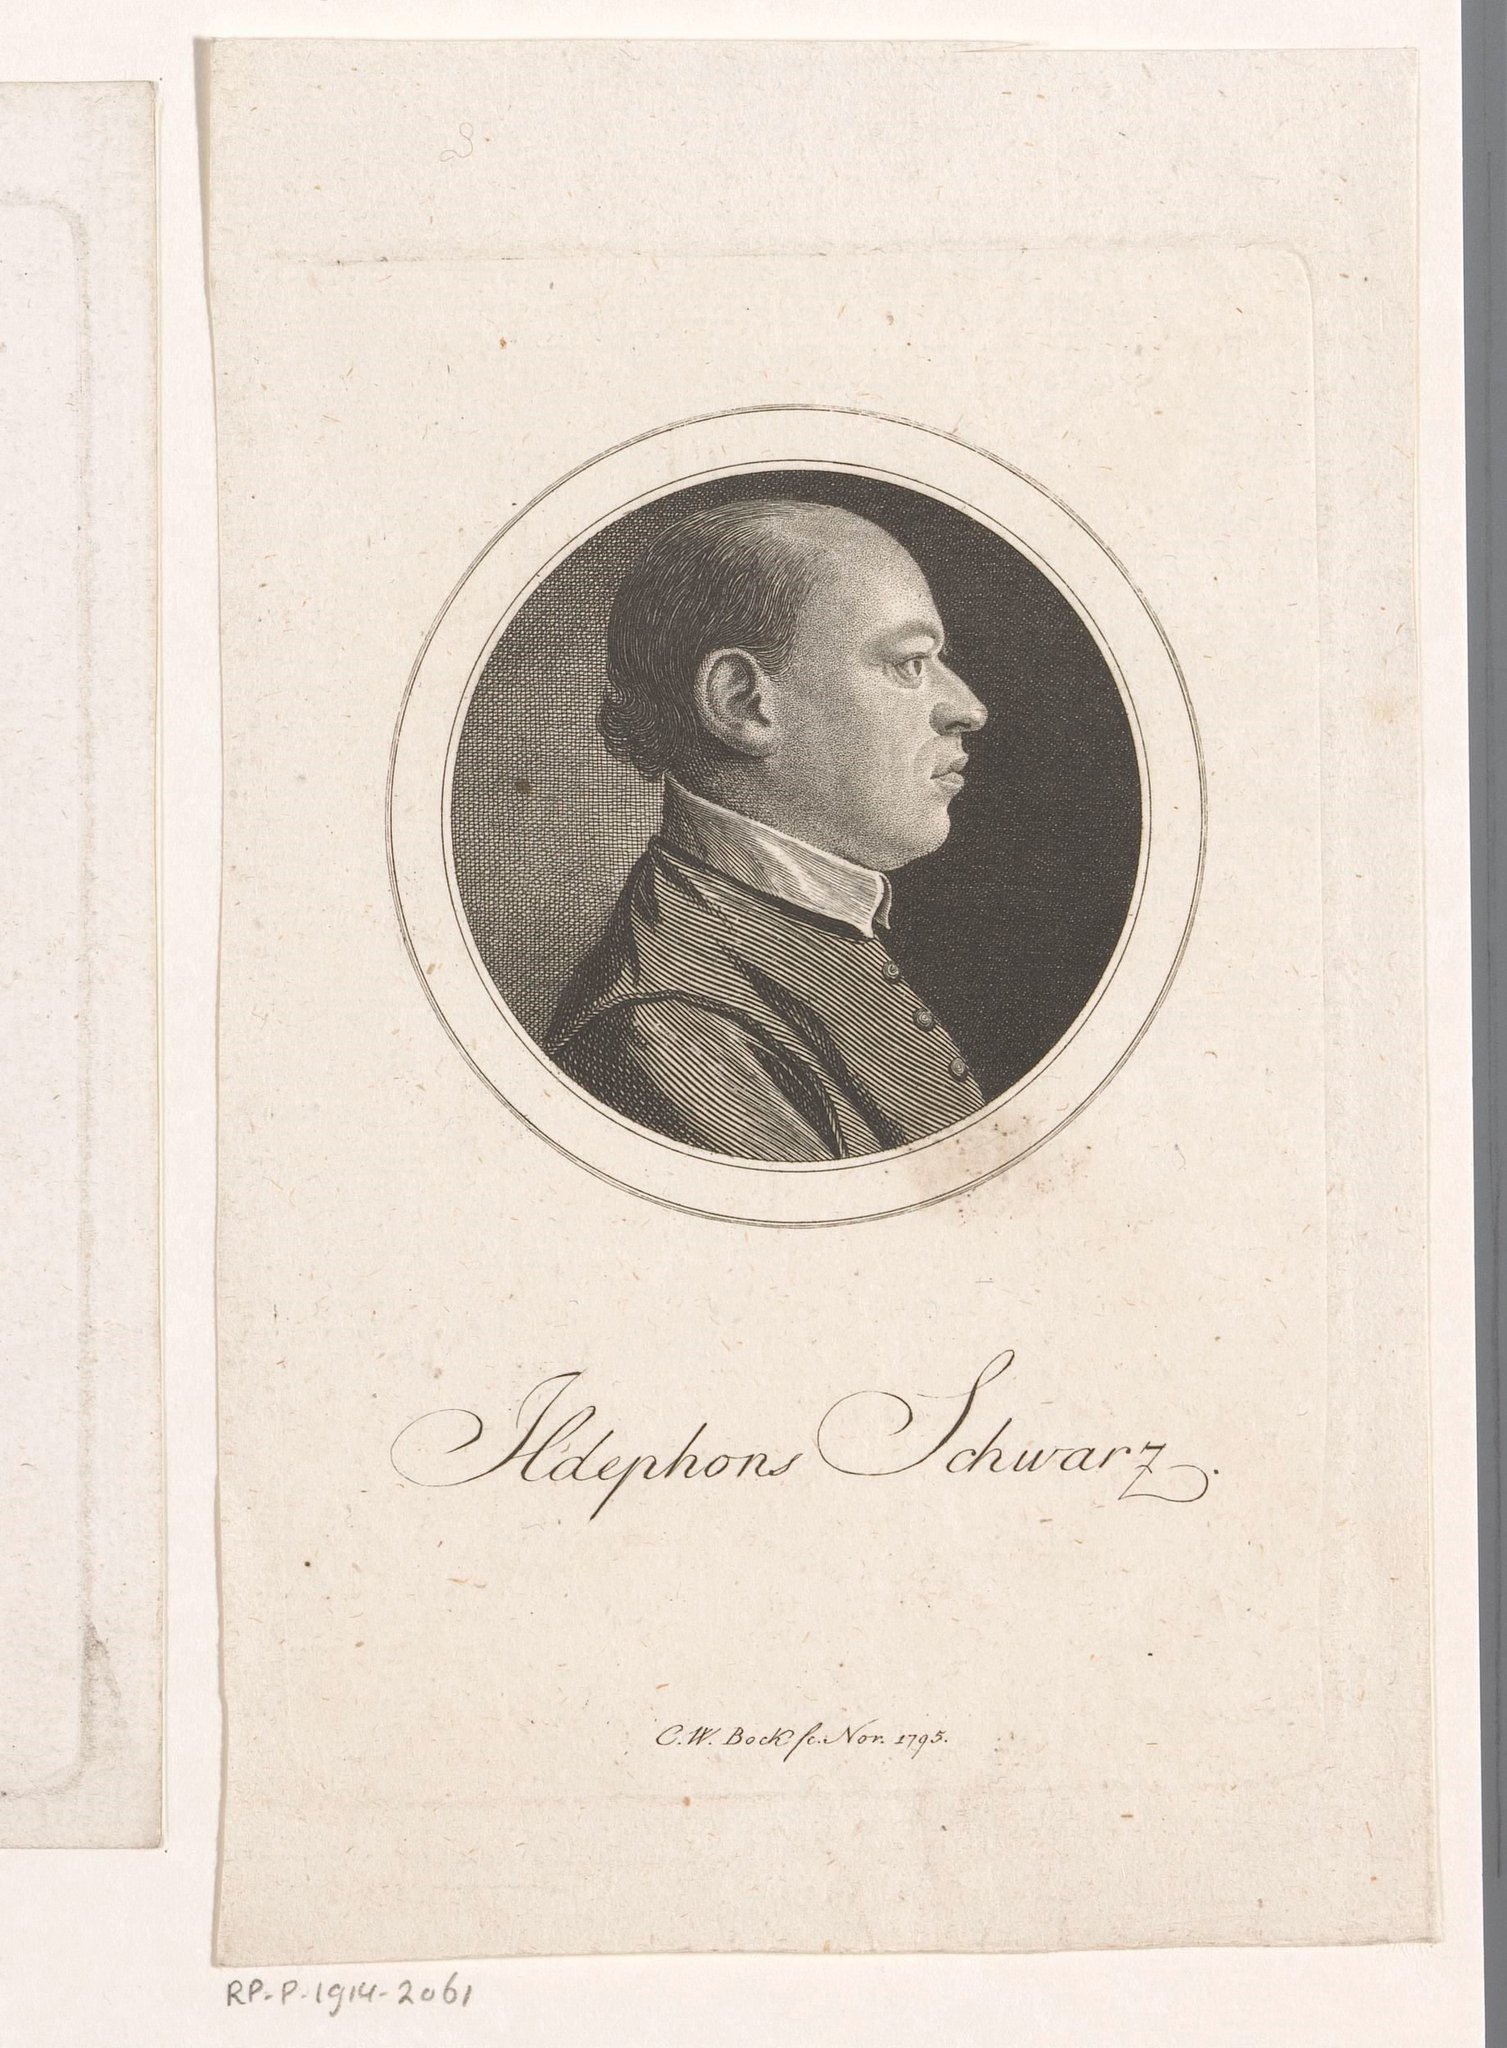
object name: print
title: Portret van Ildephons Schwarz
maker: christoph wilhelm bock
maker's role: print maker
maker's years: 1755-1836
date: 1795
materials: paper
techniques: engraving, etching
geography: nuremberg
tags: historical persons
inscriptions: collector's mark: Lugt 2228